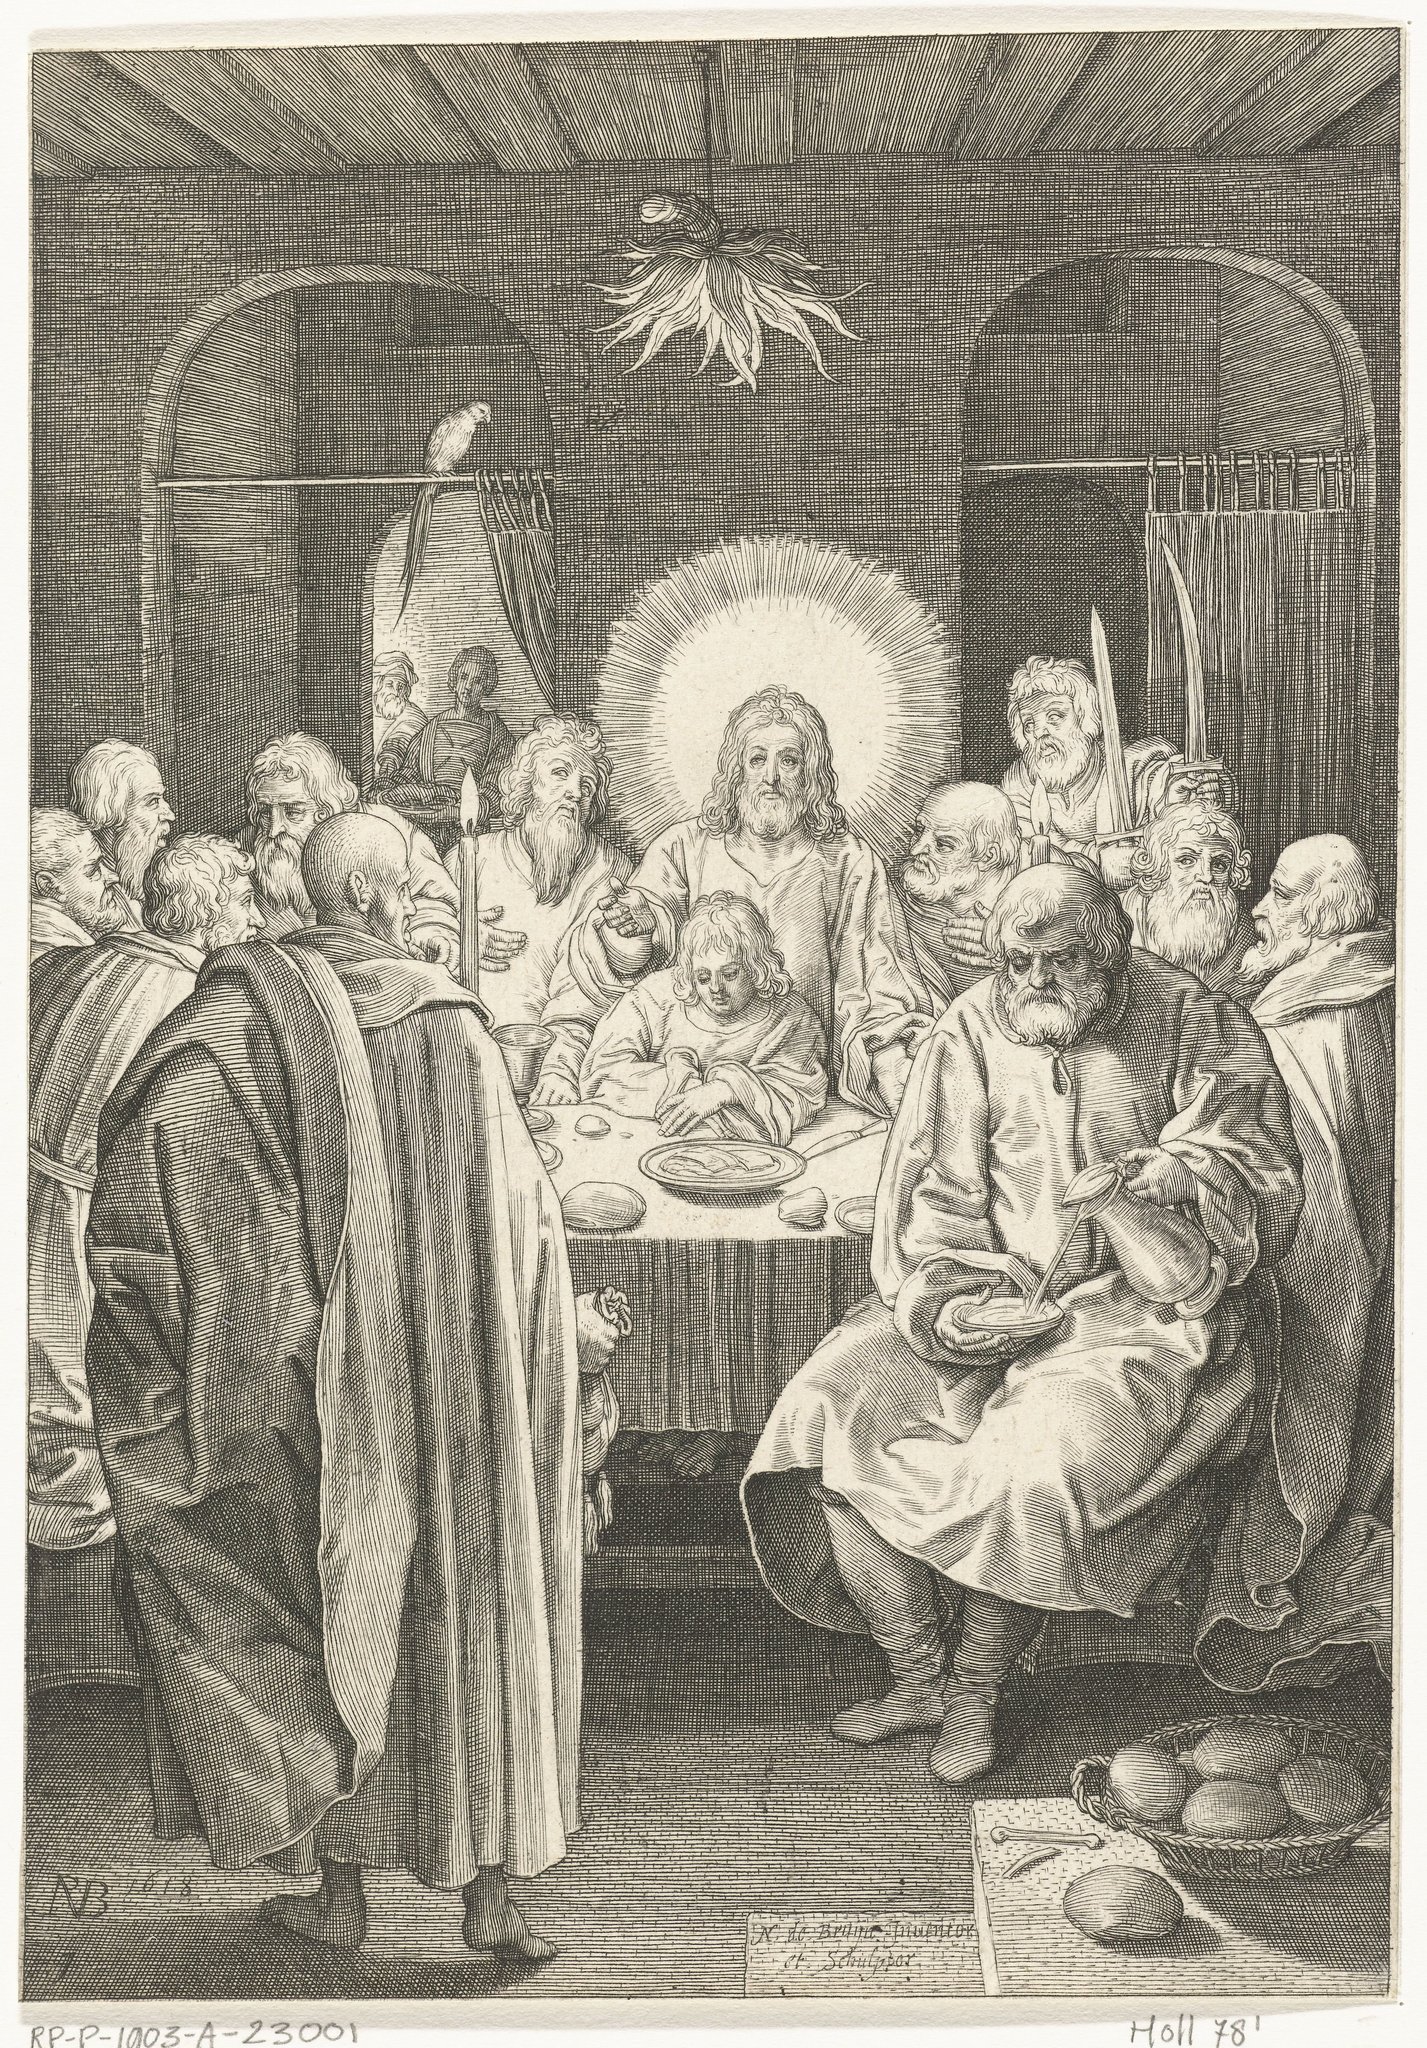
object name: print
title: De Passie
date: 1618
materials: paper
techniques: engraving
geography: netherlands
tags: last supper (in general) (matthew 26:21-35; mark 14:18-31; luke 22:3, 22:15-23; john 13:21-38)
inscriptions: collector's mark: Lugt 2228, collector's mark: Lugt 567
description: Prent uit serie van twaalf prenten met scènes uit de Passie. Reeks geïnspireerd door de prenten van Hendrick Goltzius en Lucas van Leyden.